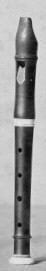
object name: flageolet in d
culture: french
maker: denis noblet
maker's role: maker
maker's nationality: french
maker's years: 1768-1839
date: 1839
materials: ivory, wood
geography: france